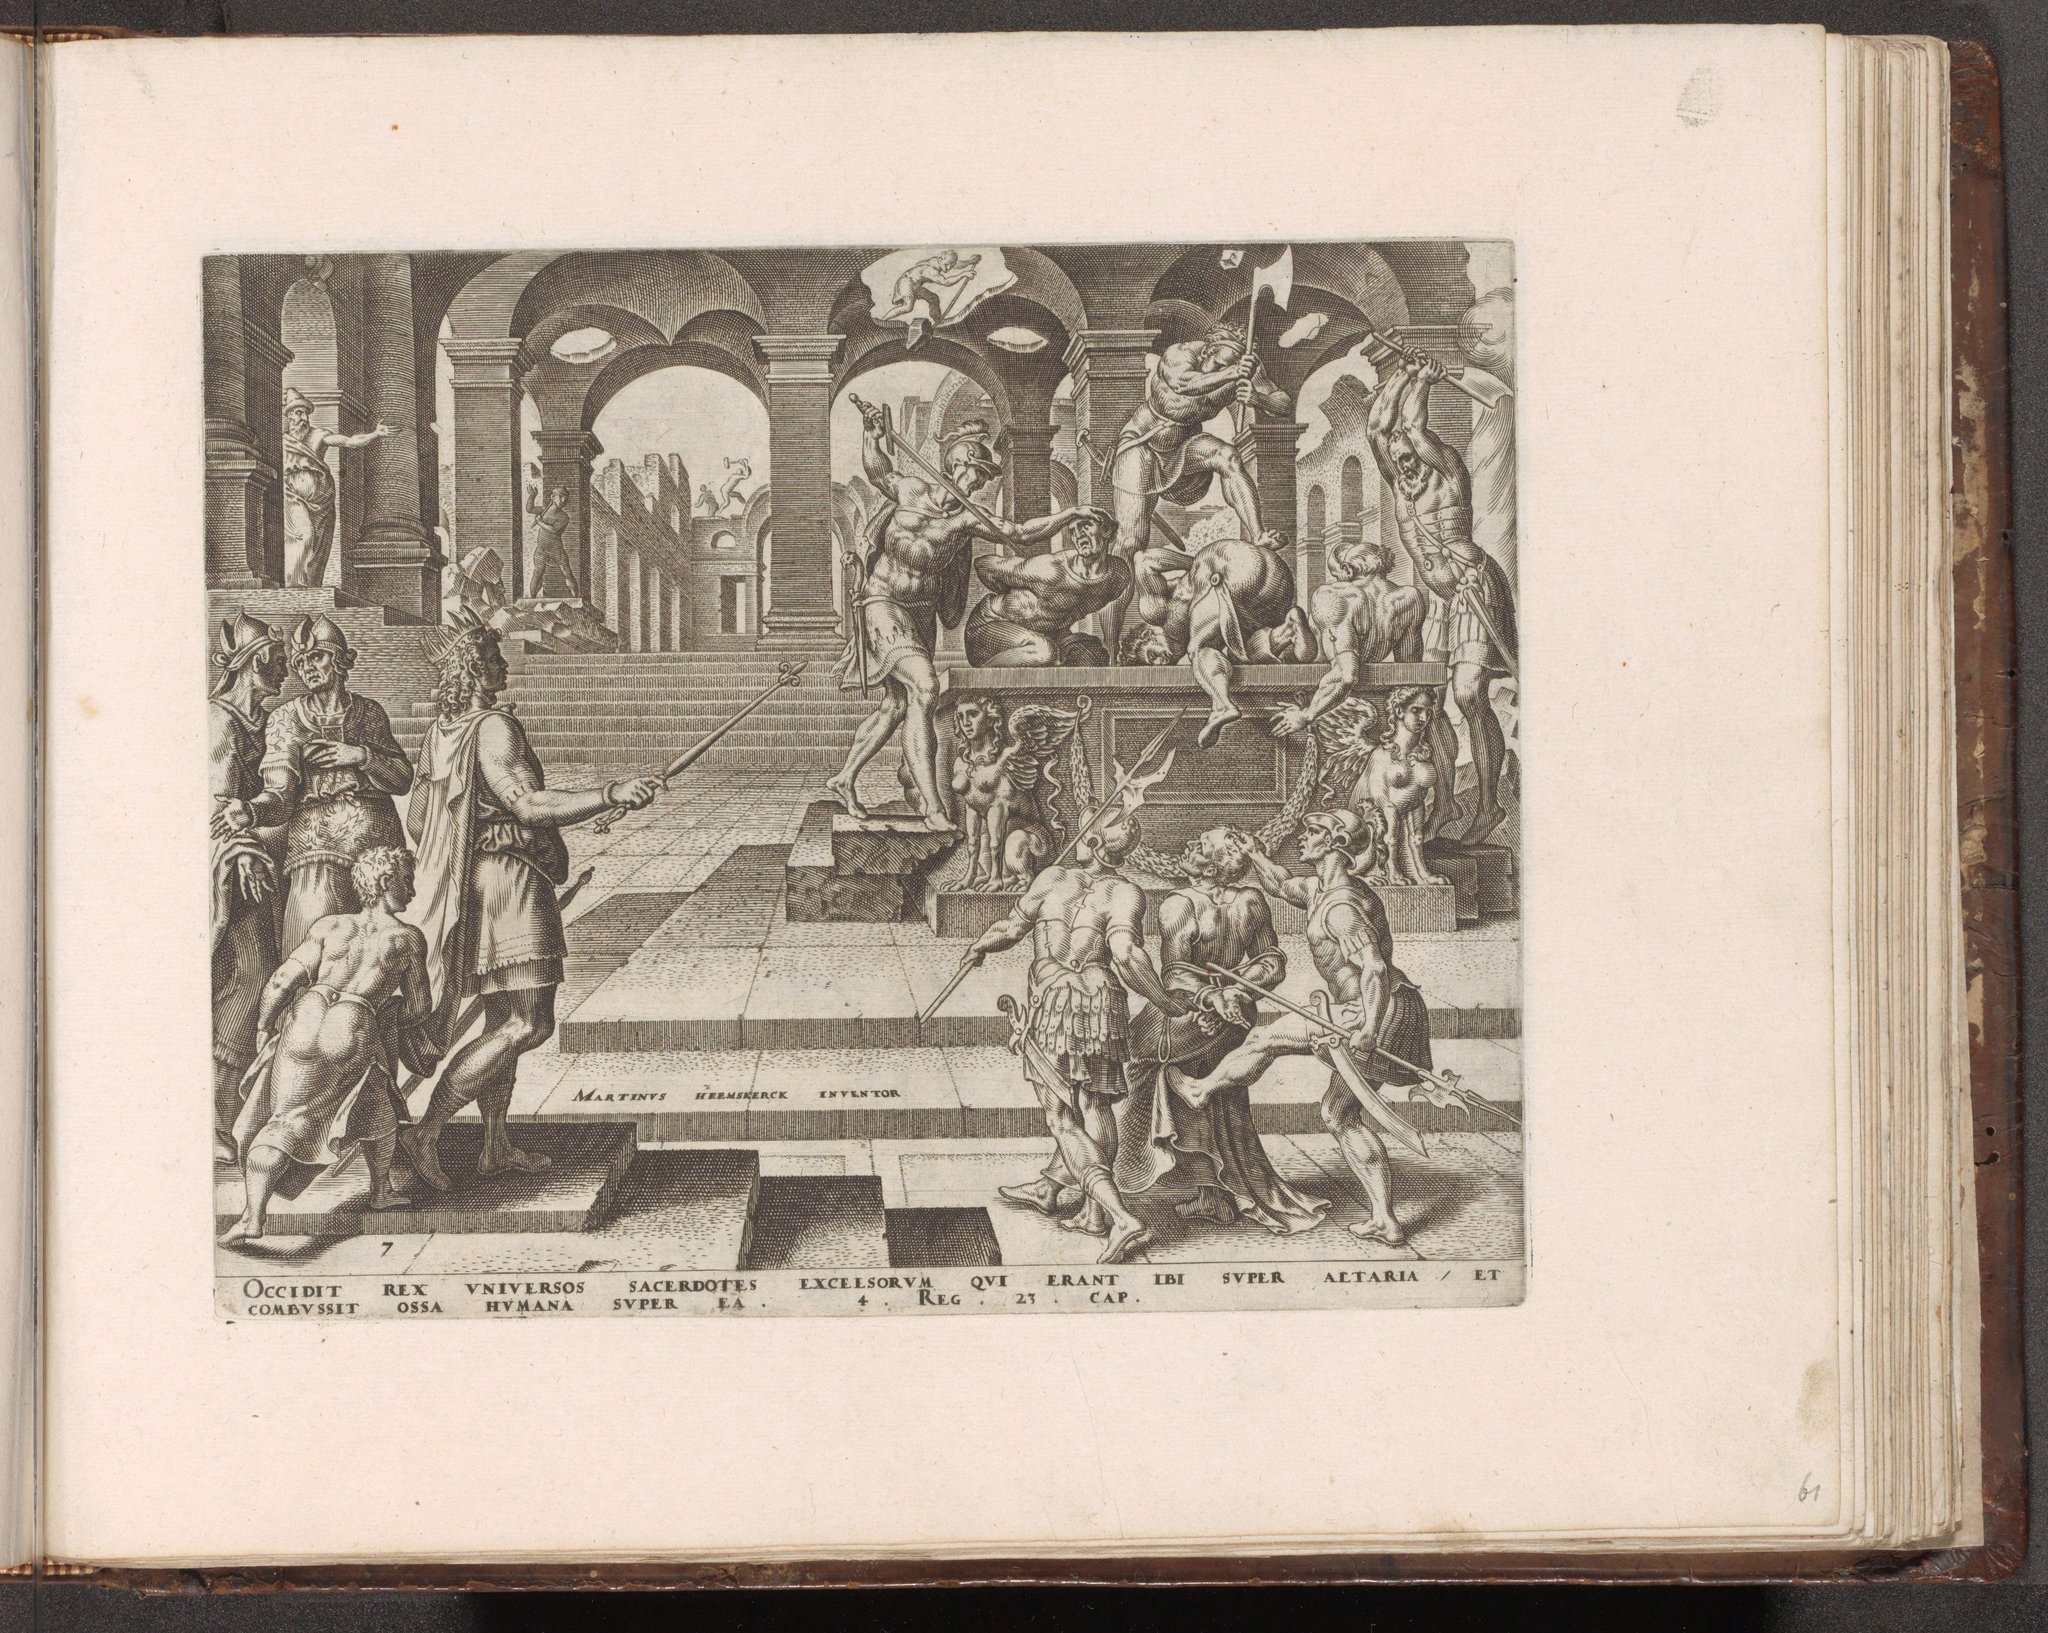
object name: album leaf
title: Koning Josia geeft opdracht de priesters van de tempels in Samaria te vermoorden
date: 1567-1571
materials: paper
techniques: engraving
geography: antwerp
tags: the pagan priests are either killed or suppressed ~ story of josiah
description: Koning Josia staat in de tempel van Samaria en laat de priesters op de offeraltaren vermoorden. Soldaten van Josia slaan de priesters met bijlen en zwaarden. Onder de voorstelling een verwijzing in het Latijn naar de Bijbeltekst in 2 Kon. 23:20. Prent maakt deel uit van een album.